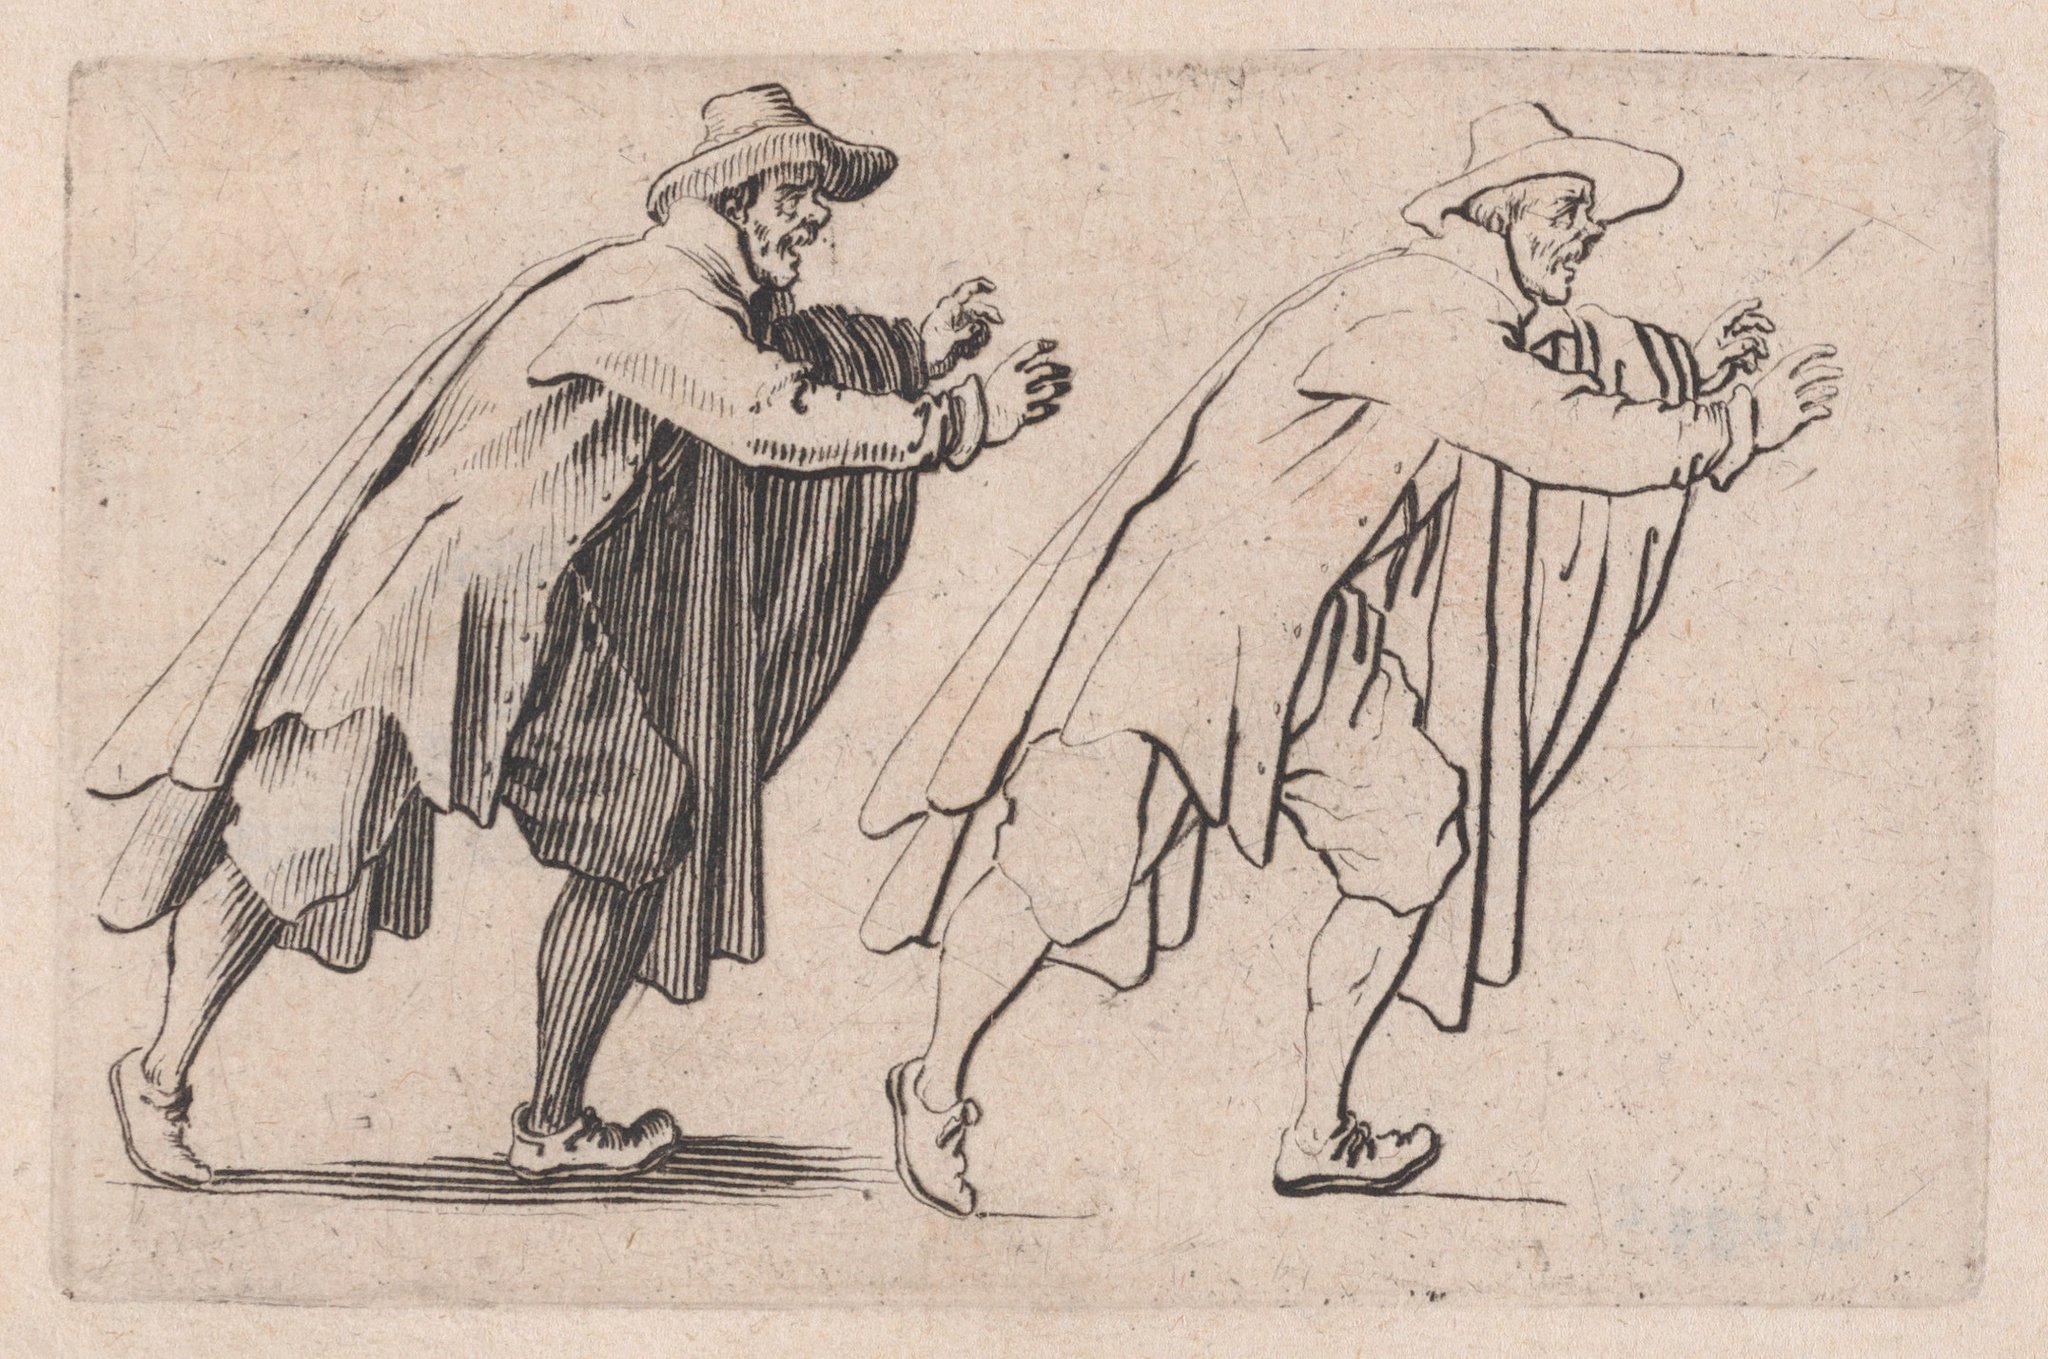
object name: print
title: L'Homme qui Court (The Running Man), from "Les Caprices" Series B, The Nancy Set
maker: jacques callot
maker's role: artist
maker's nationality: french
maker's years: 1592-1635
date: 1617-1620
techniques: etching